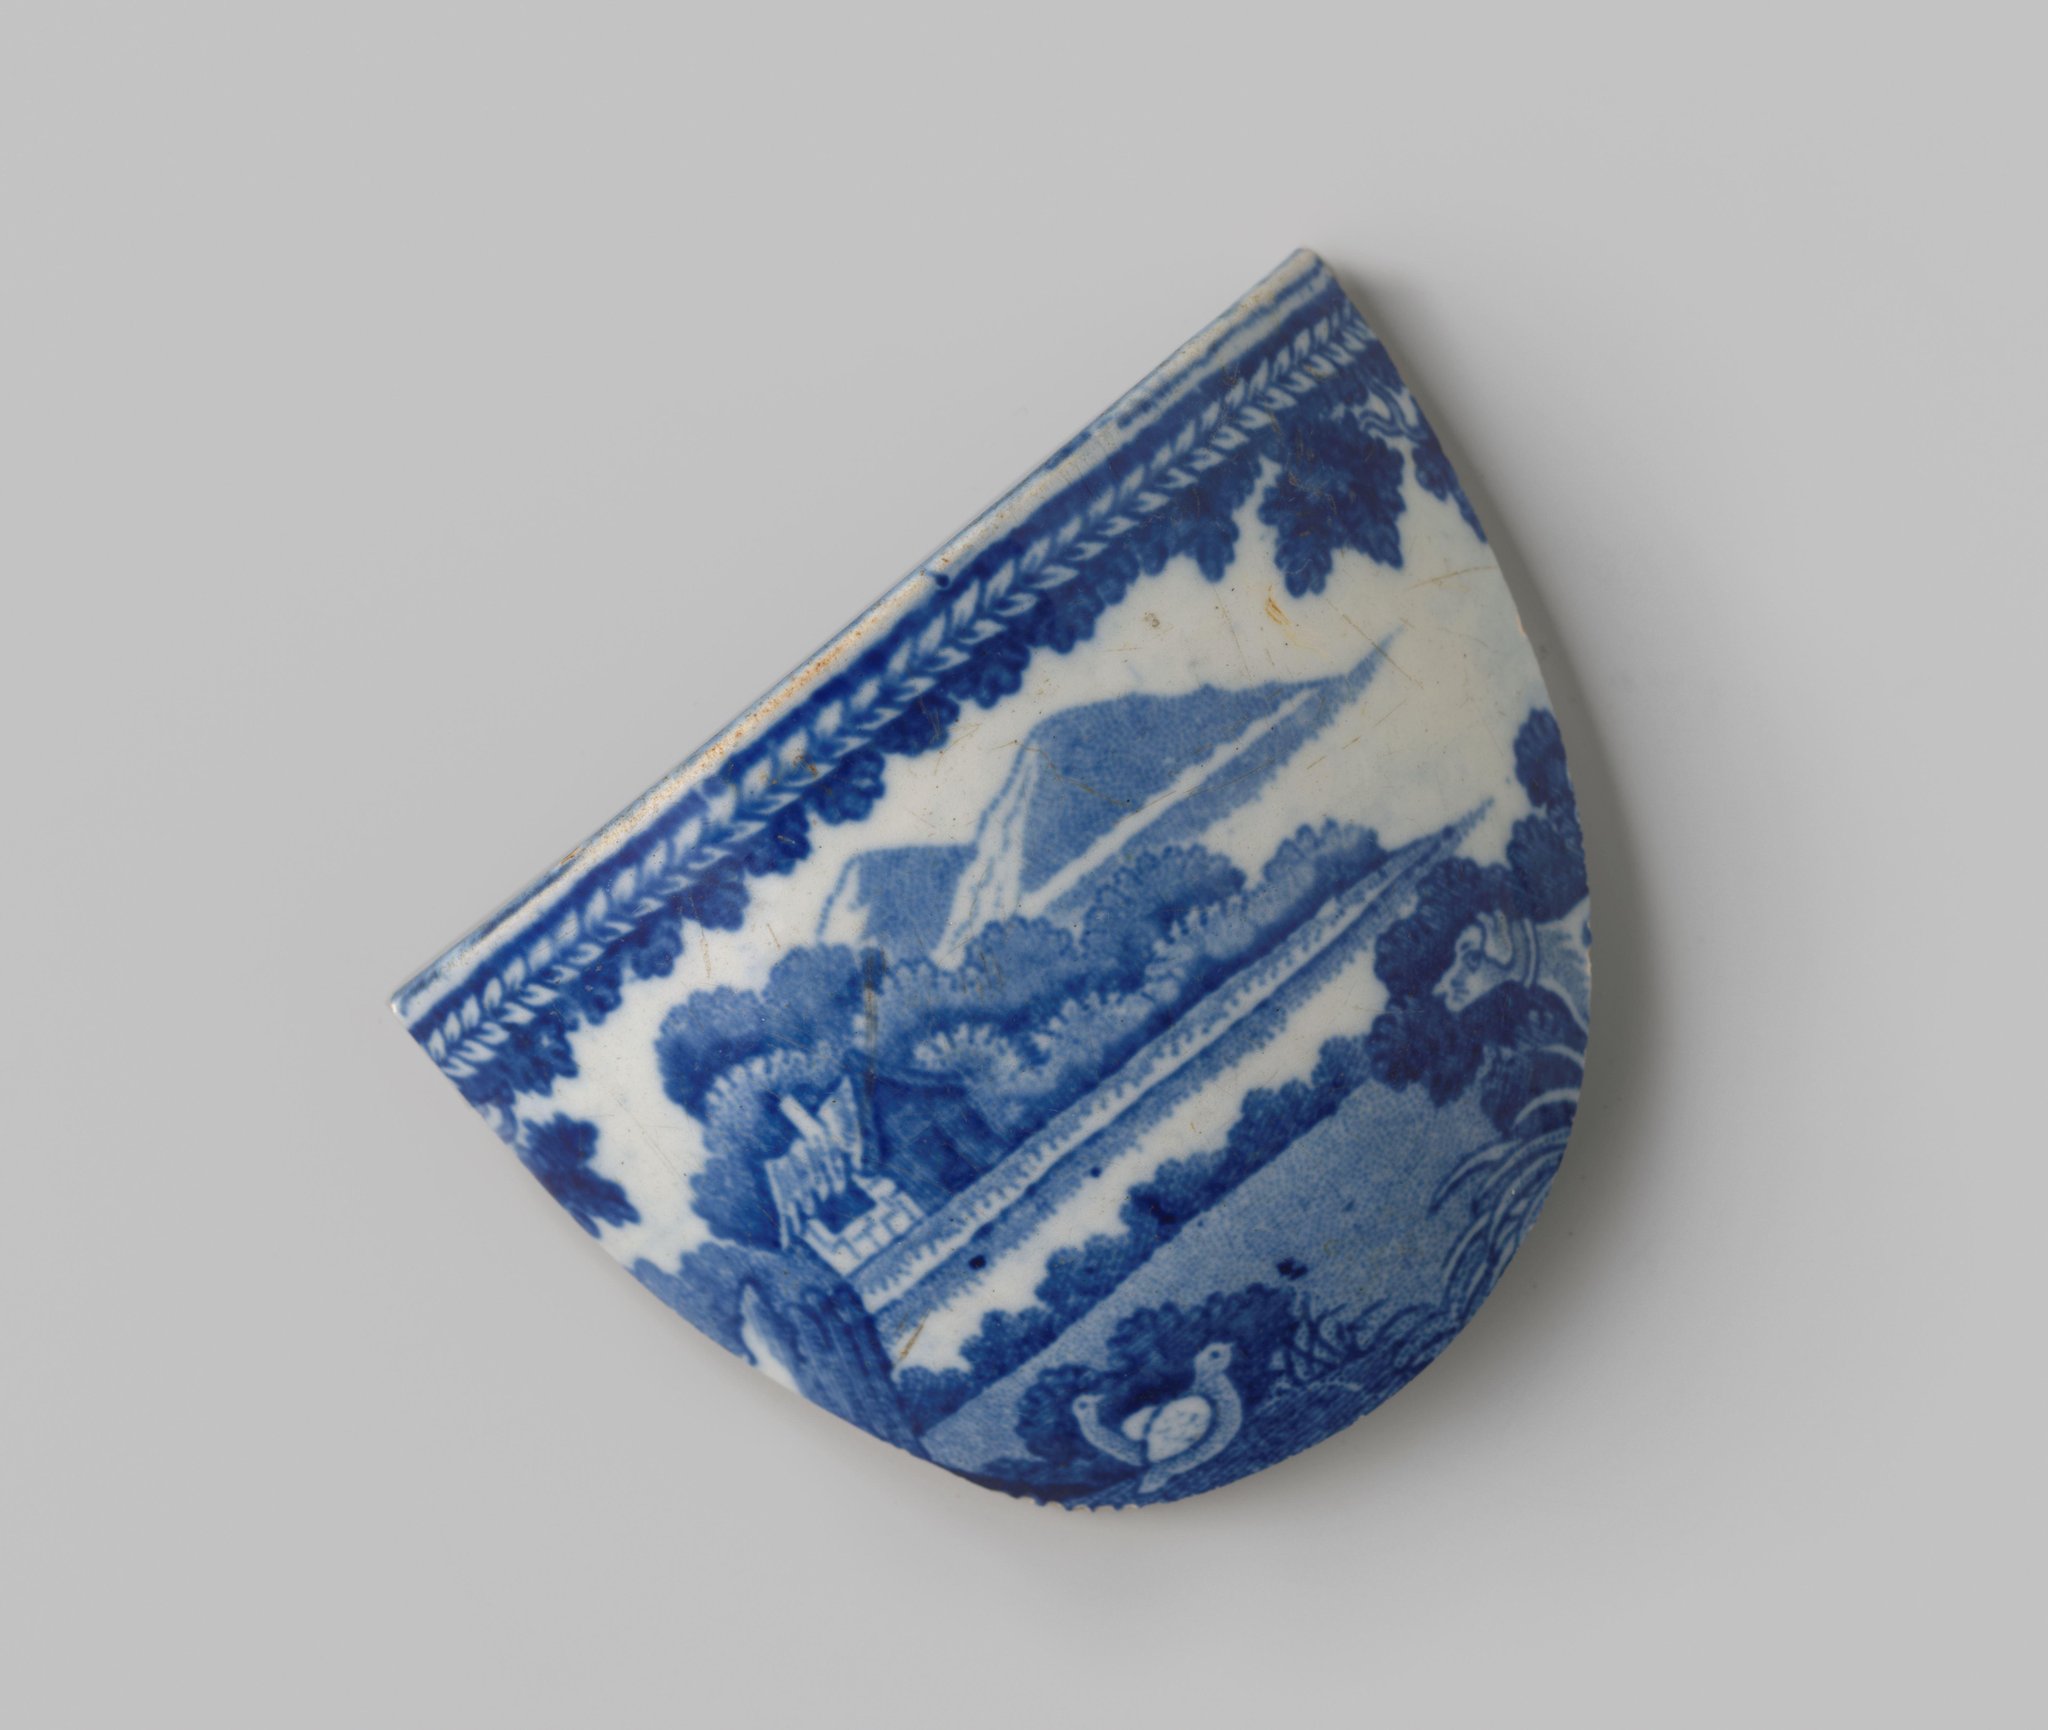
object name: sherd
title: Scherf van witbakkend aardewerk, met een drukdecor in blauw, aan de binnenzijde met een geometrisch patroon en aan de buitenzijde met een landschap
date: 1500-1899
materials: earthenware, glaze